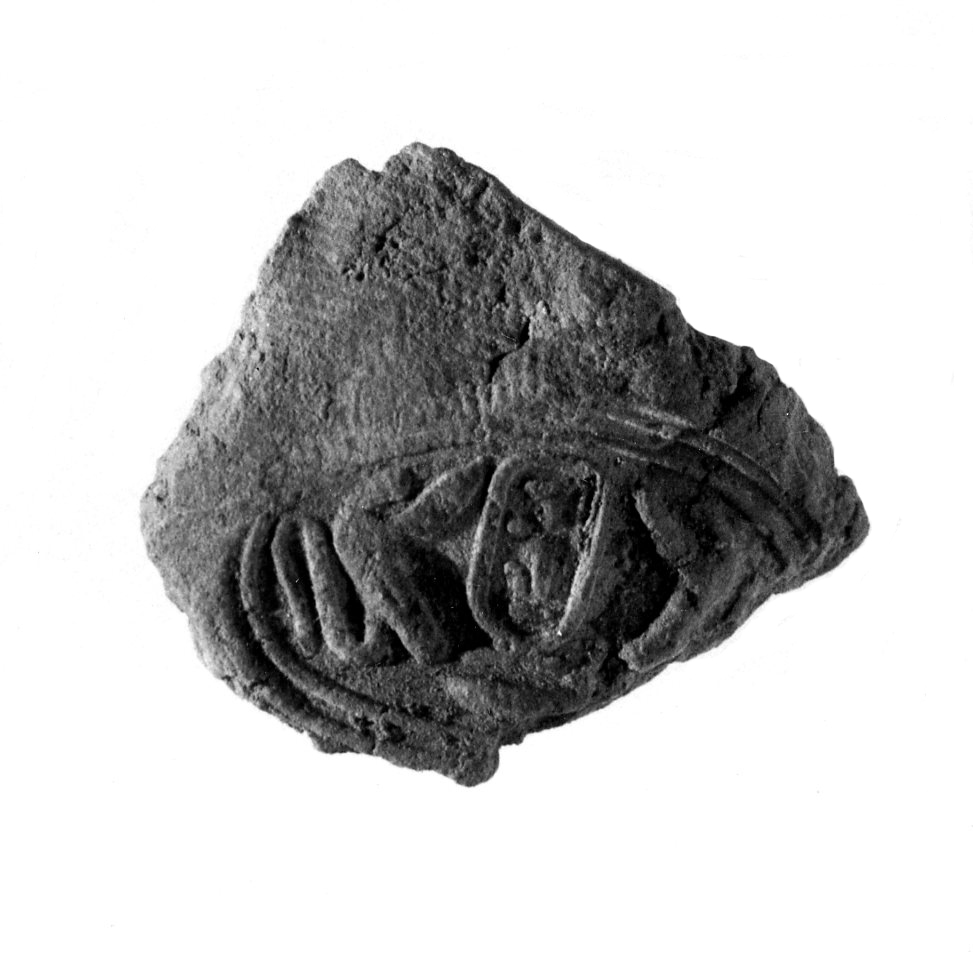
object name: sealing, amenhotep iii, nebmaatre. winged cobra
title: Document Sealing with the Throne Name of Amenhotep III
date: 1390-1352 BCE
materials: mud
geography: egypt